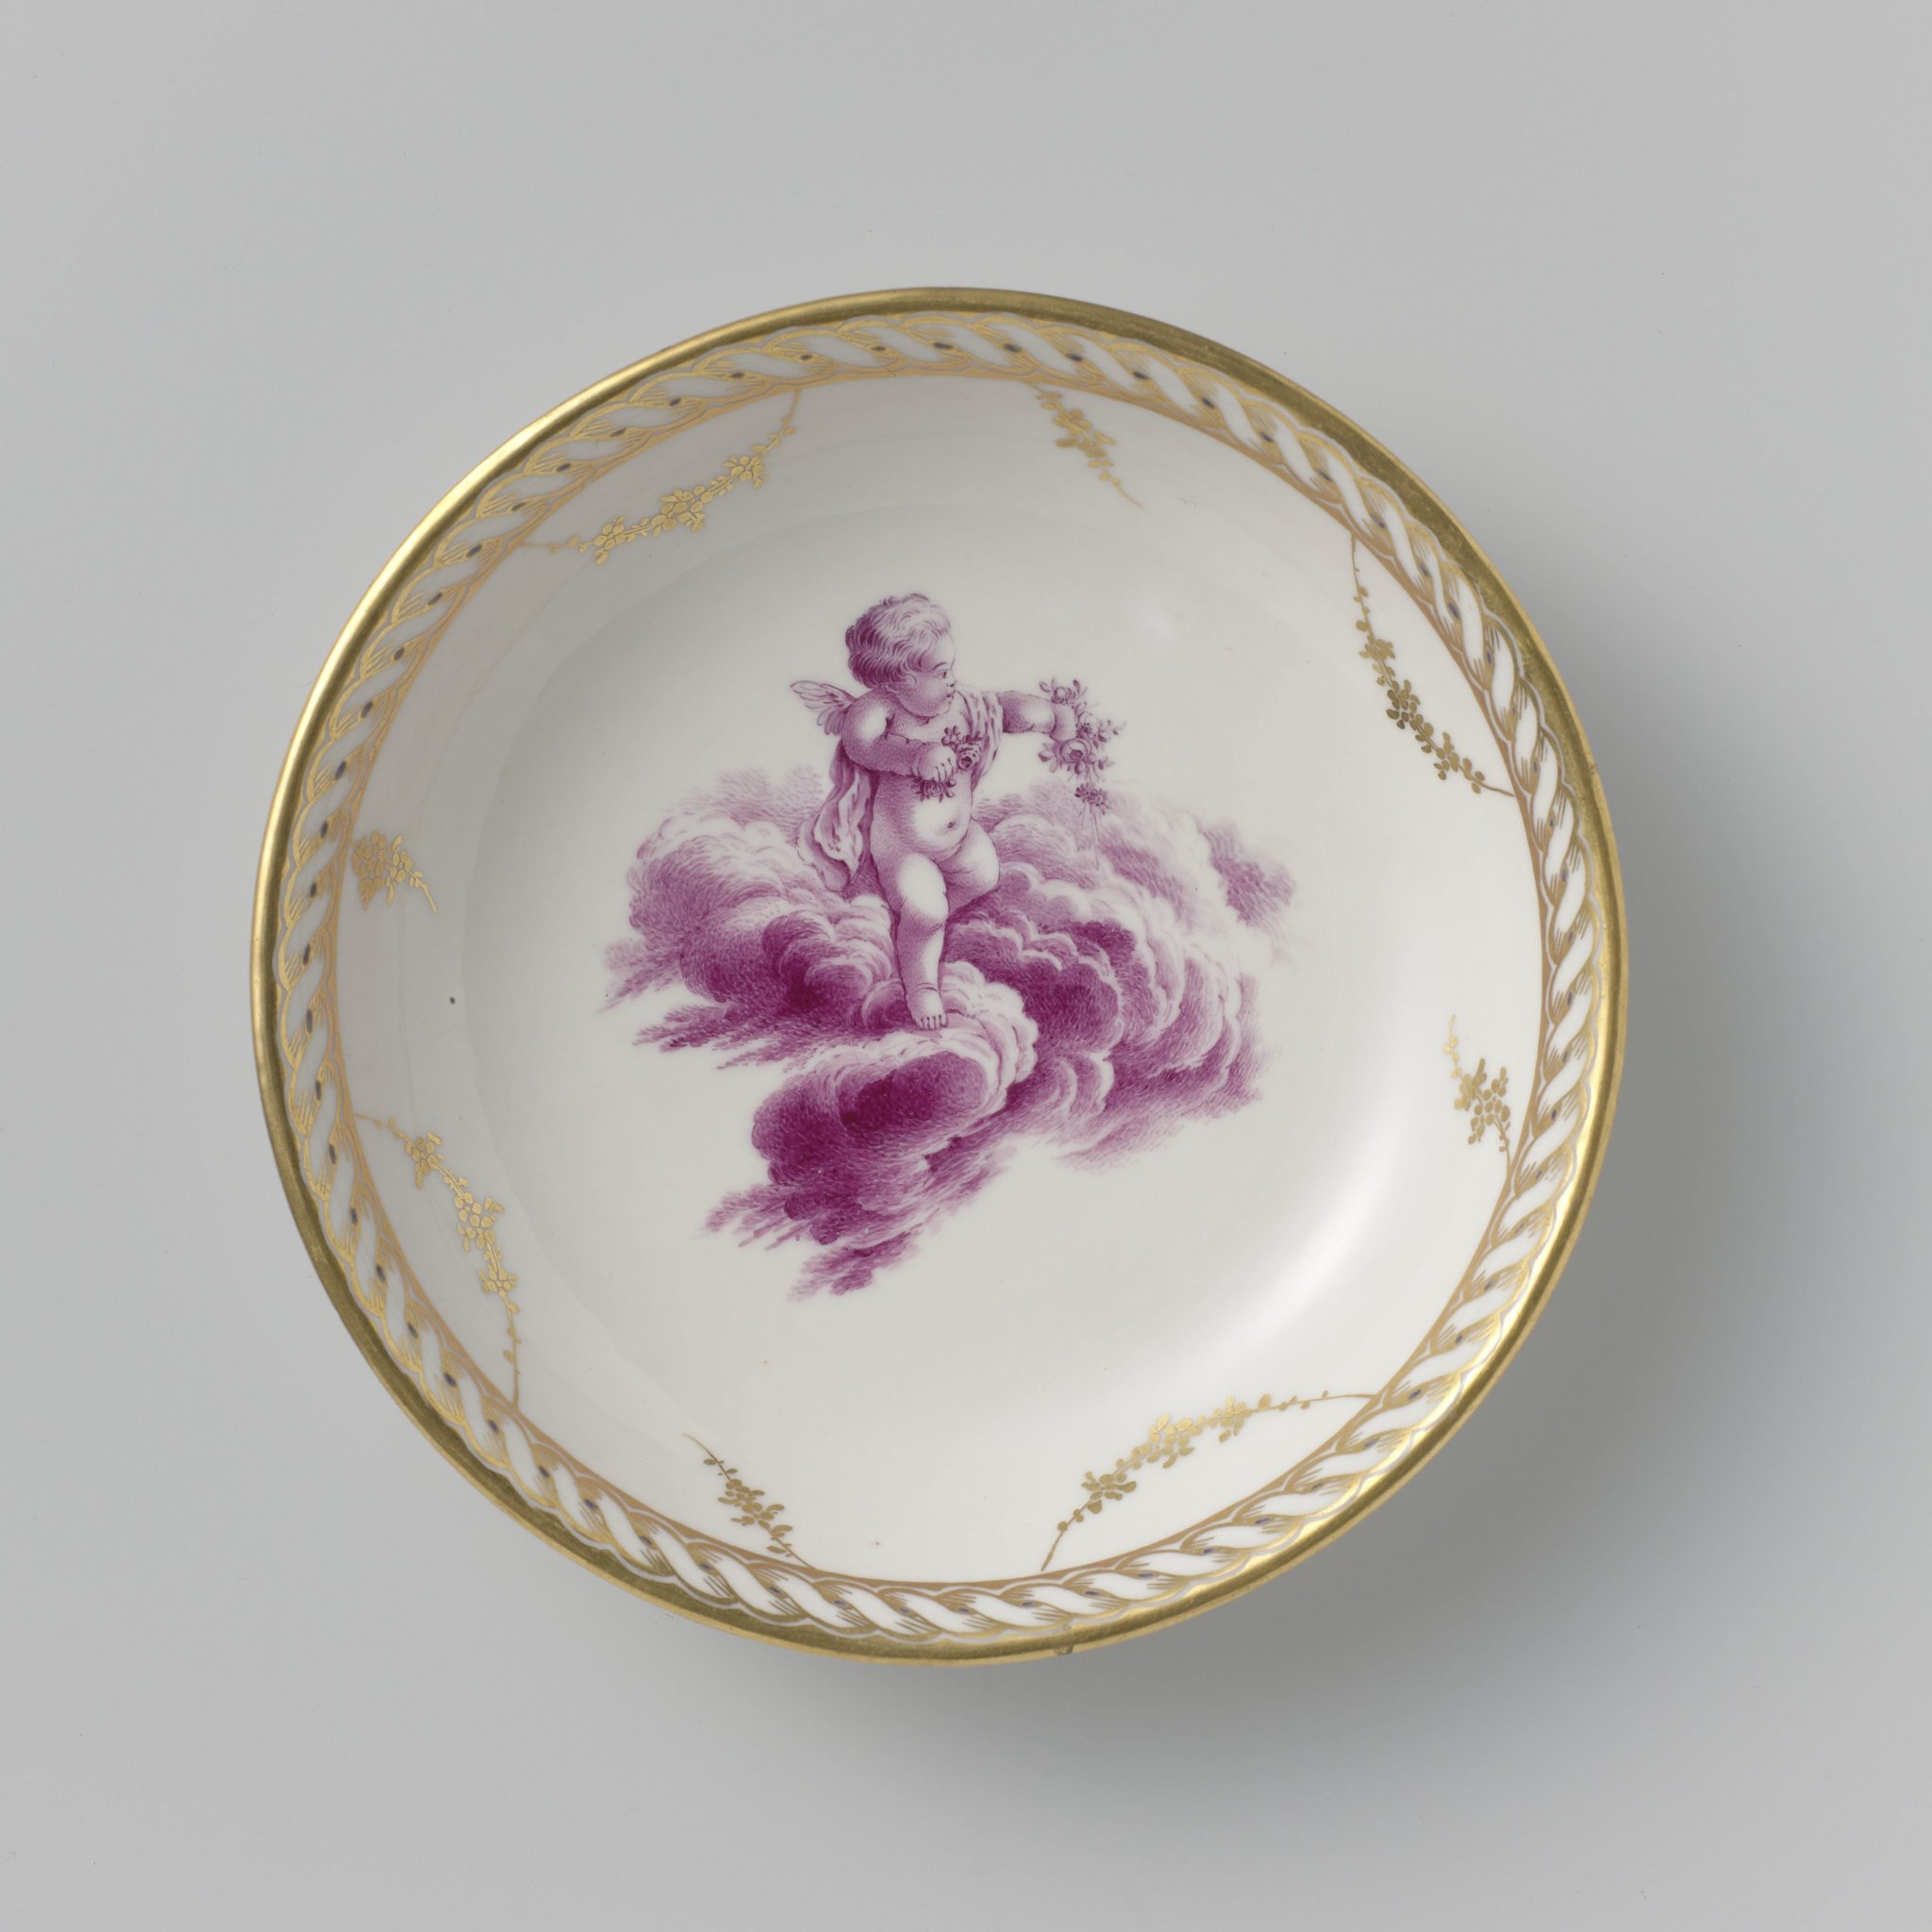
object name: platter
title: Saucer with a putto on clouds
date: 1785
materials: glaze, gold, paint, porcelain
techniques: firing, forming, gilding, turning, vitrification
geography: the hague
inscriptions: mark: ‘ooievaar’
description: Schotel van porselein, beschilderd op het glazuur in roze (camaïeu) en goud. Op het plat een putto op een wolk, hij heeft beide handen vol bloemen. De binnenrand met een gedraaide band, waaraan guirlandes en bloemtakken hangen. Gouden rand. Gemerkt op de onderzijde met de ooievaar.